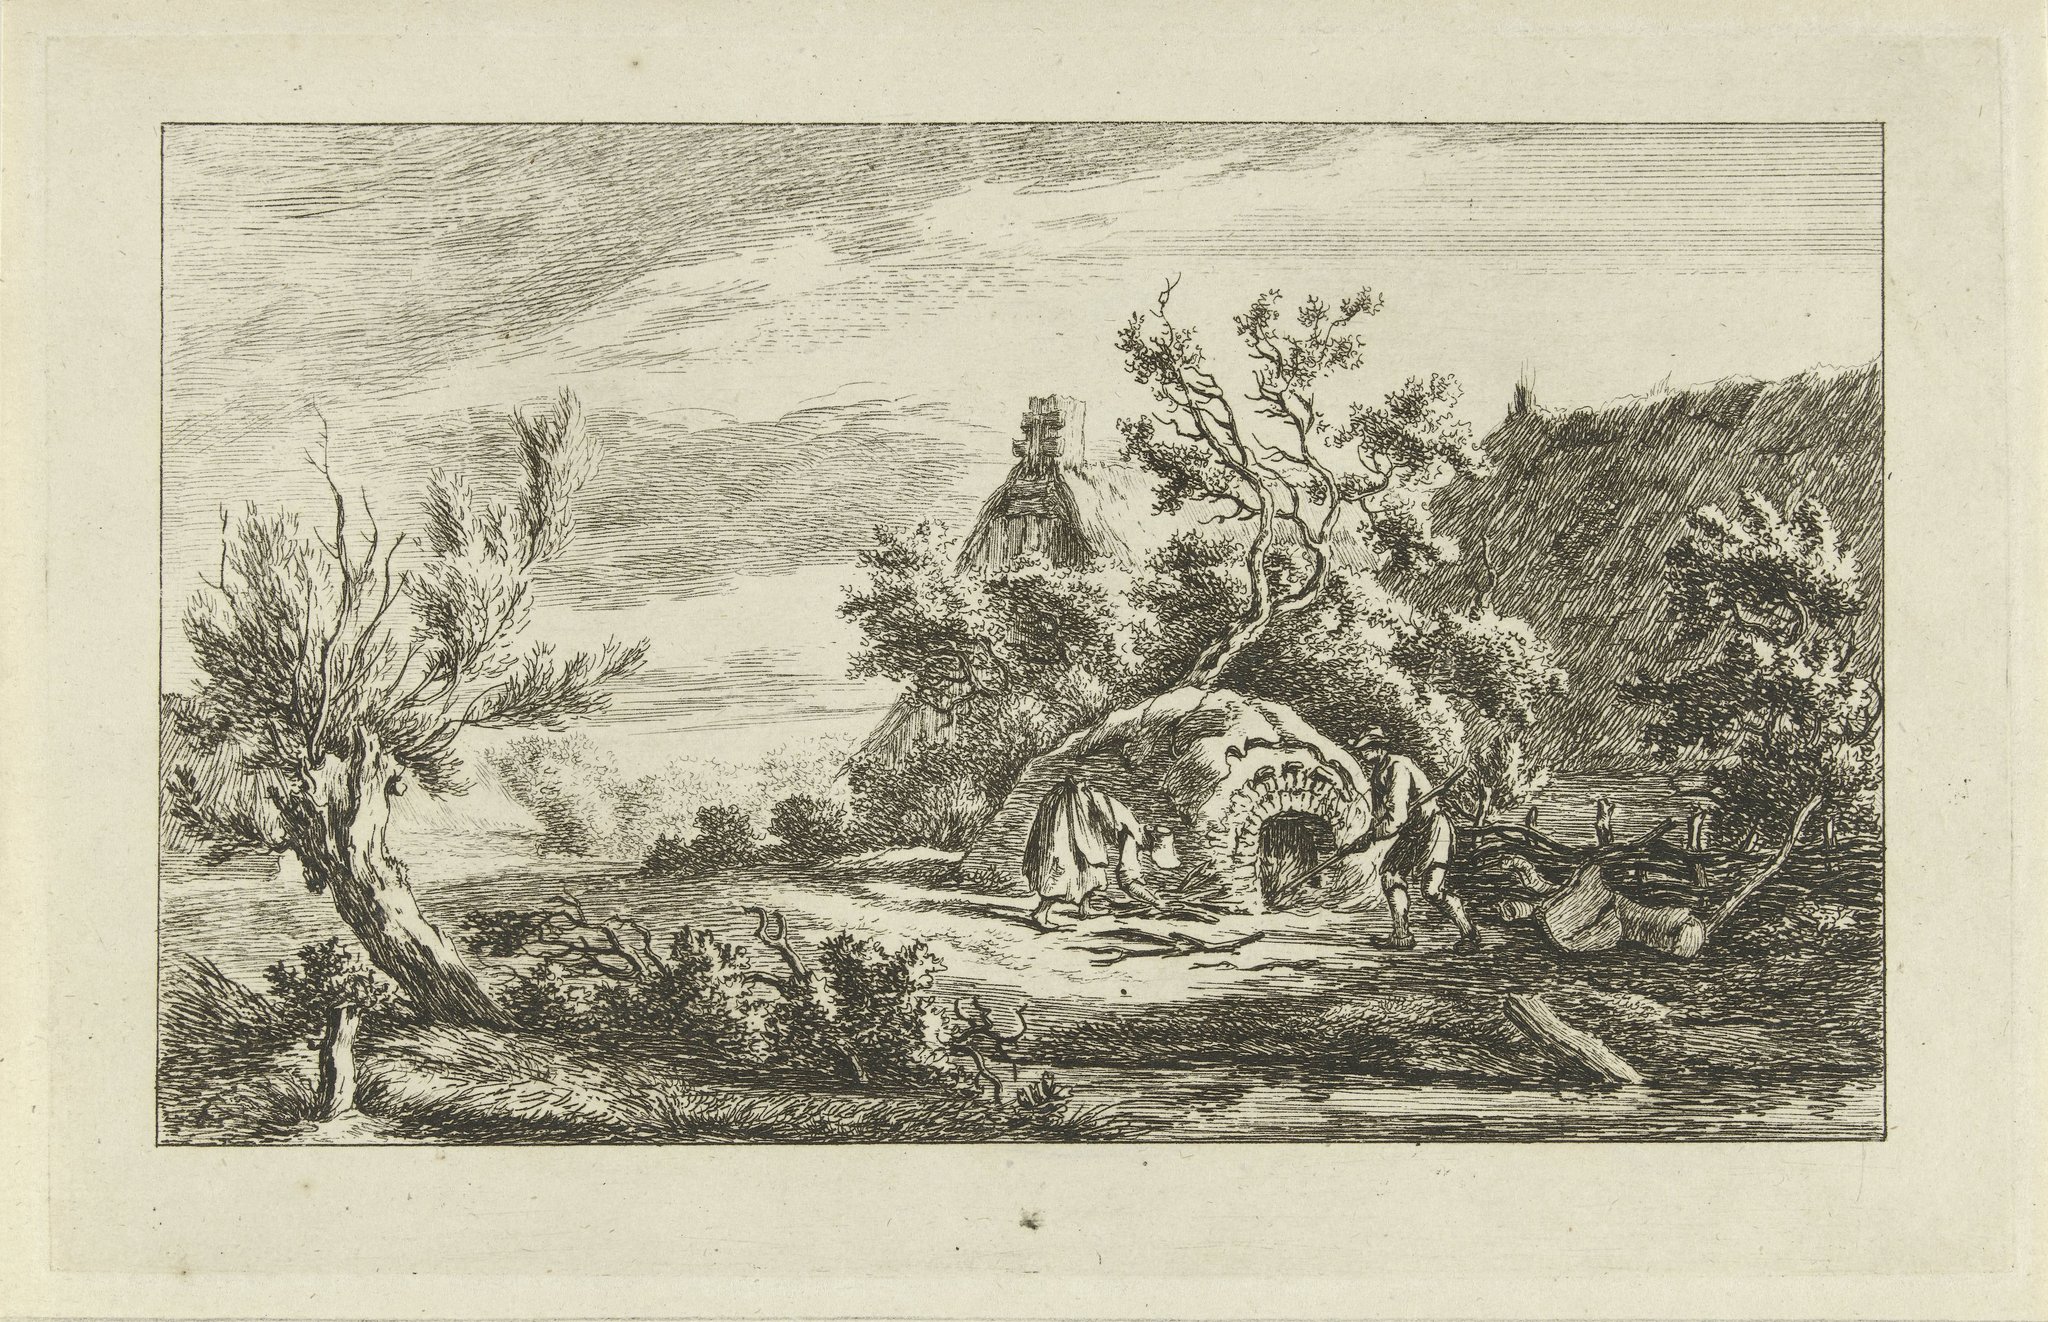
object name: print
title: Landschappen (a-f)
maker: carel lodewijk hansen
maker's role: draughtsman, painter, print maker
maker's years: 1765-1840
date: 1780-1840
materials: paper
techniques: etching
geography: netherlands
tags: farm or solitary house in landscape, oven ~ kitchen - cc - in the open air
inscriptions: collector's mark: Lugt 2228